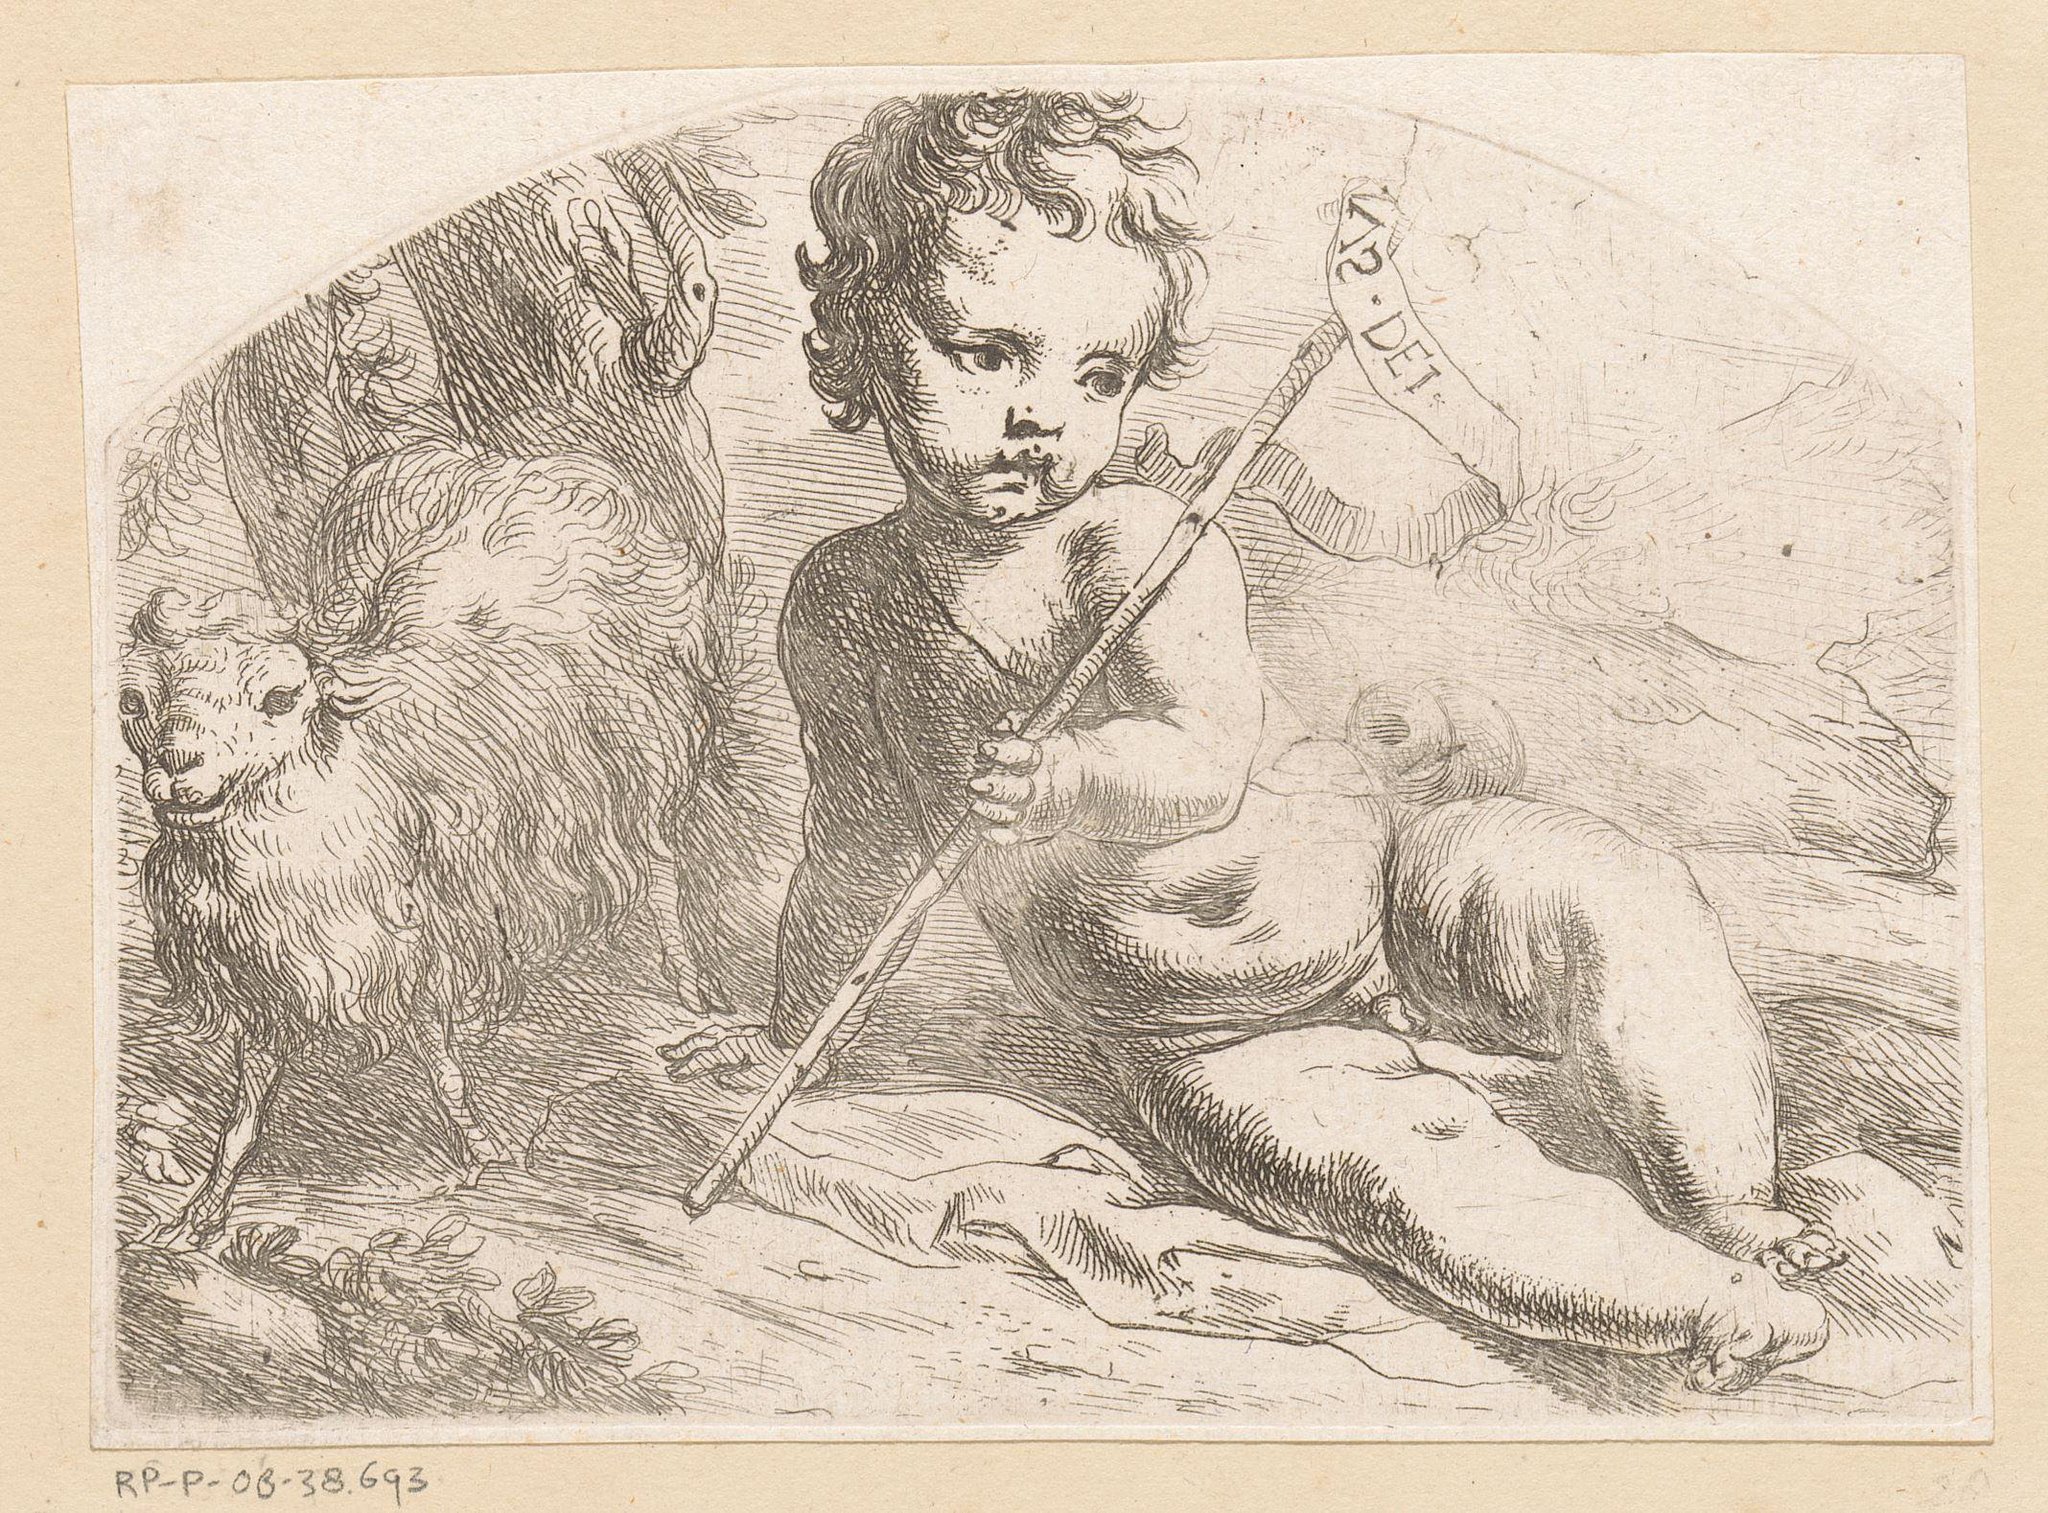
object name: print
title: Johannes de Doper als kind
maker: Anonymous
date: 1595-1692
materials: paper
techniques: etching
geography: italy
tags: john the baptist; possible attributes: book, reed cross, baptismal cup, honeycomb, lamb, staff - early life of male saint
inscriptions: collector's mark: Lugt 240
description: Johannes de Doper in een landschap met links het lam.